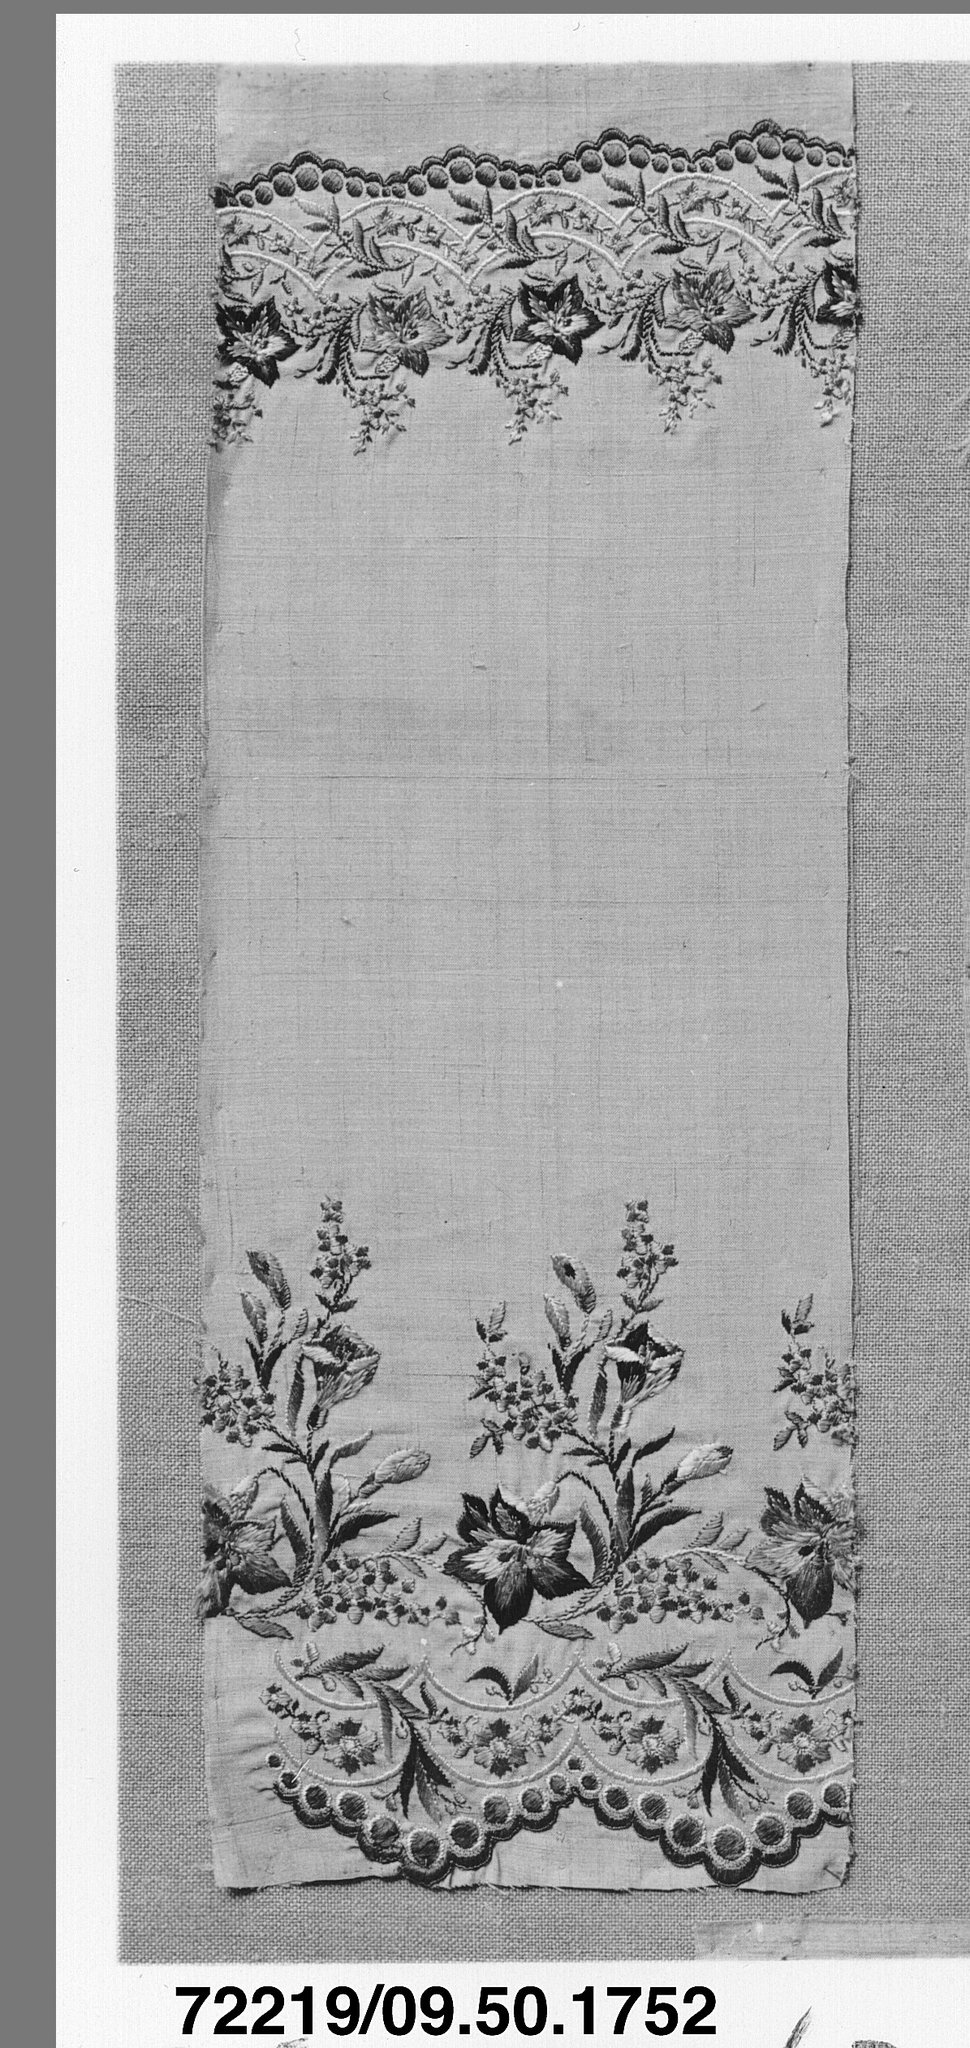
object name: fragment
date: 1801-1900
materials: silk